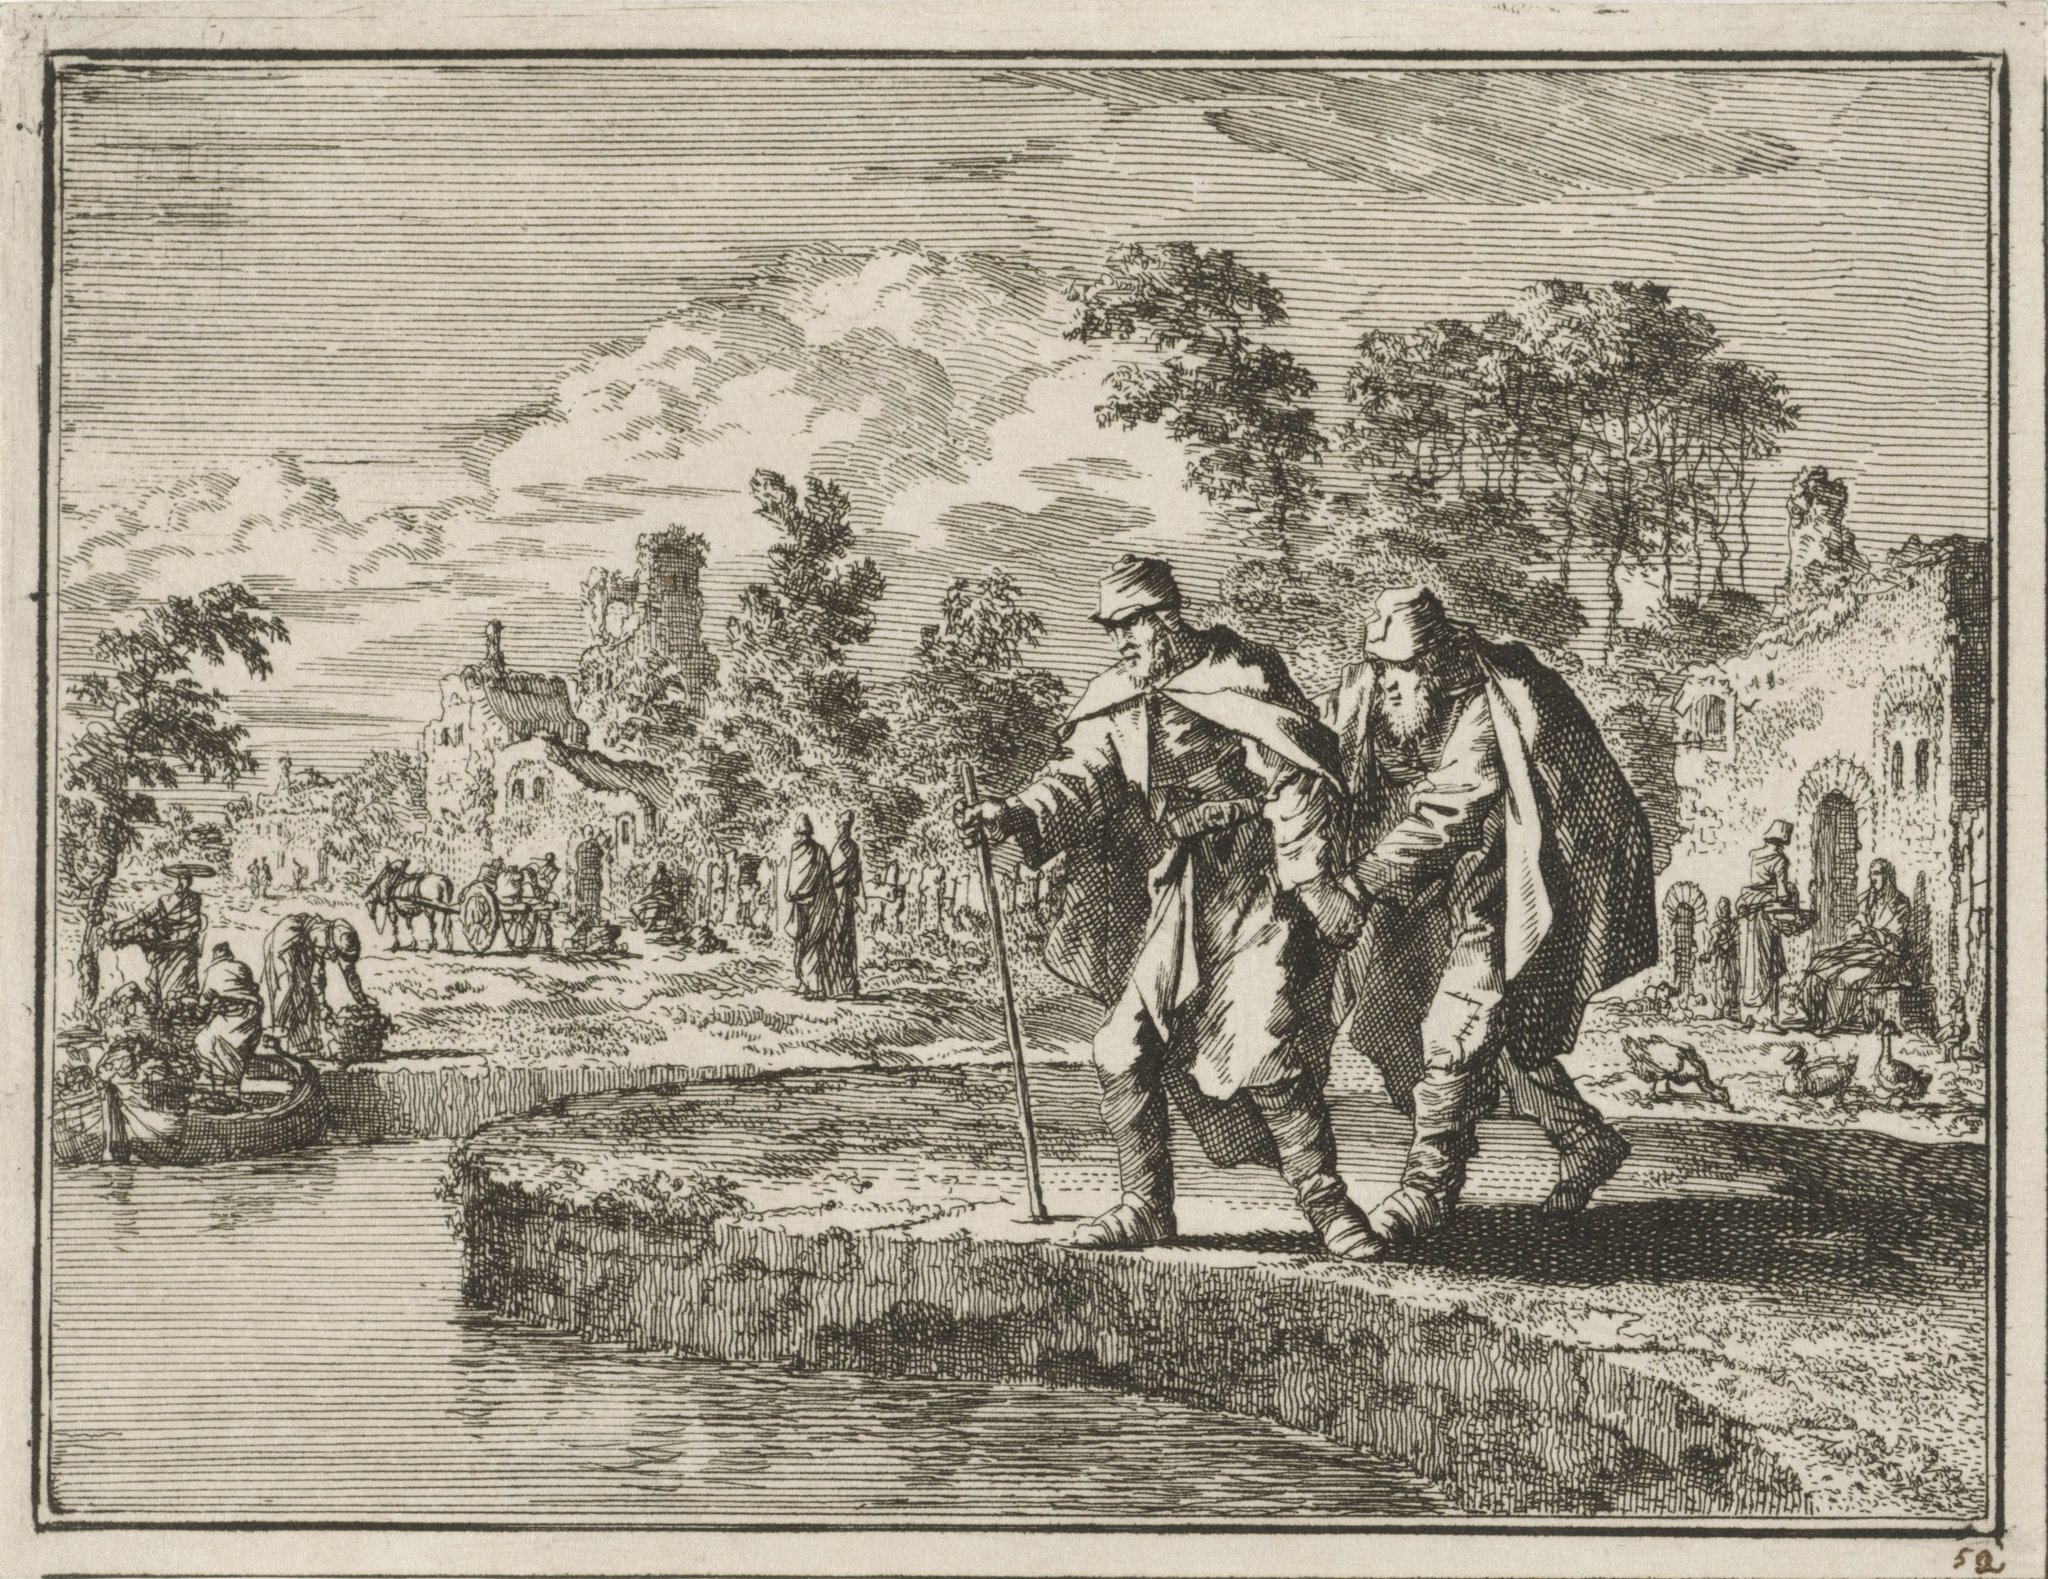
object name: print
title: De blinde leidt de blinde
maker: jan luyken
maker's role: draughtsman, print maker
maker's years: 1649-1712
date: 1712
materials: paper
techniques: etching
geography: amsterdam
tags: the blind leading the blind (matthew 15:14)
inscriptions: collector's mark: Lugt 2228, number: ‘52’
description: Proefdruk van illustratie uit: Luyken, Jan. De schriftuurlyke geschiedenissen en gelykenissen van het Oude en Nieuwe Verbond, 2 delen. Amsterdam: Wed. Pieter Arentsz II en Cornelis van der Sys, 1712, dl. II.